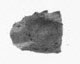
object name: shard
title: Shard (Study Collection)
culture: chinese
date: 1644-1911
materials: amber, ceramic, glaze